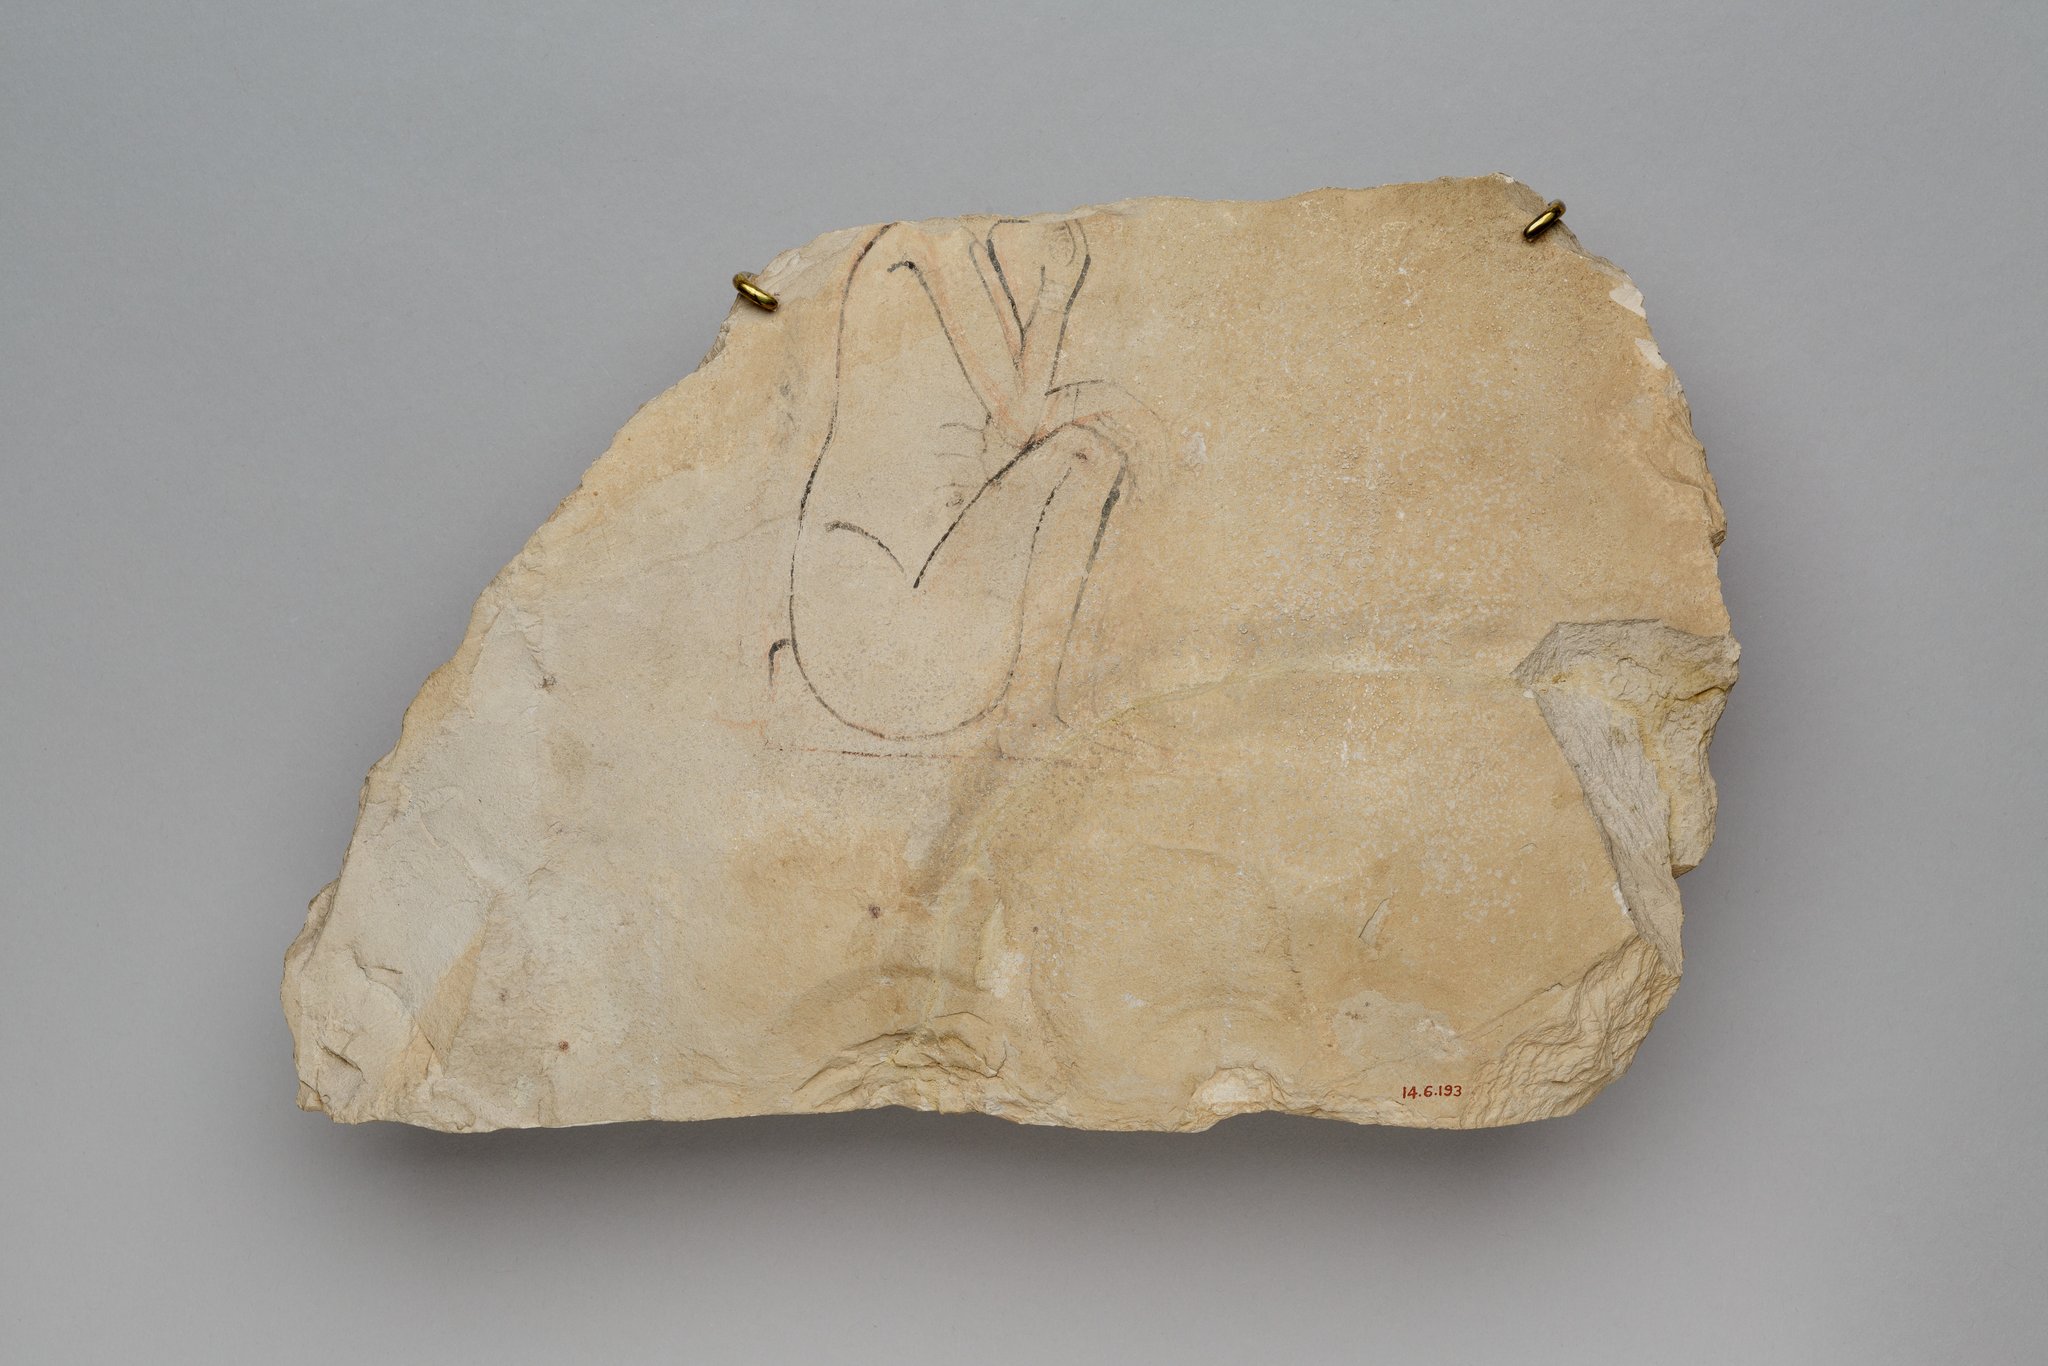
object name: ostracon, figured, child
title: Ostracon with Seated Child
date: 1295-1070 BCE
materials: ink, limestone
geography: egypt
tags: human figures